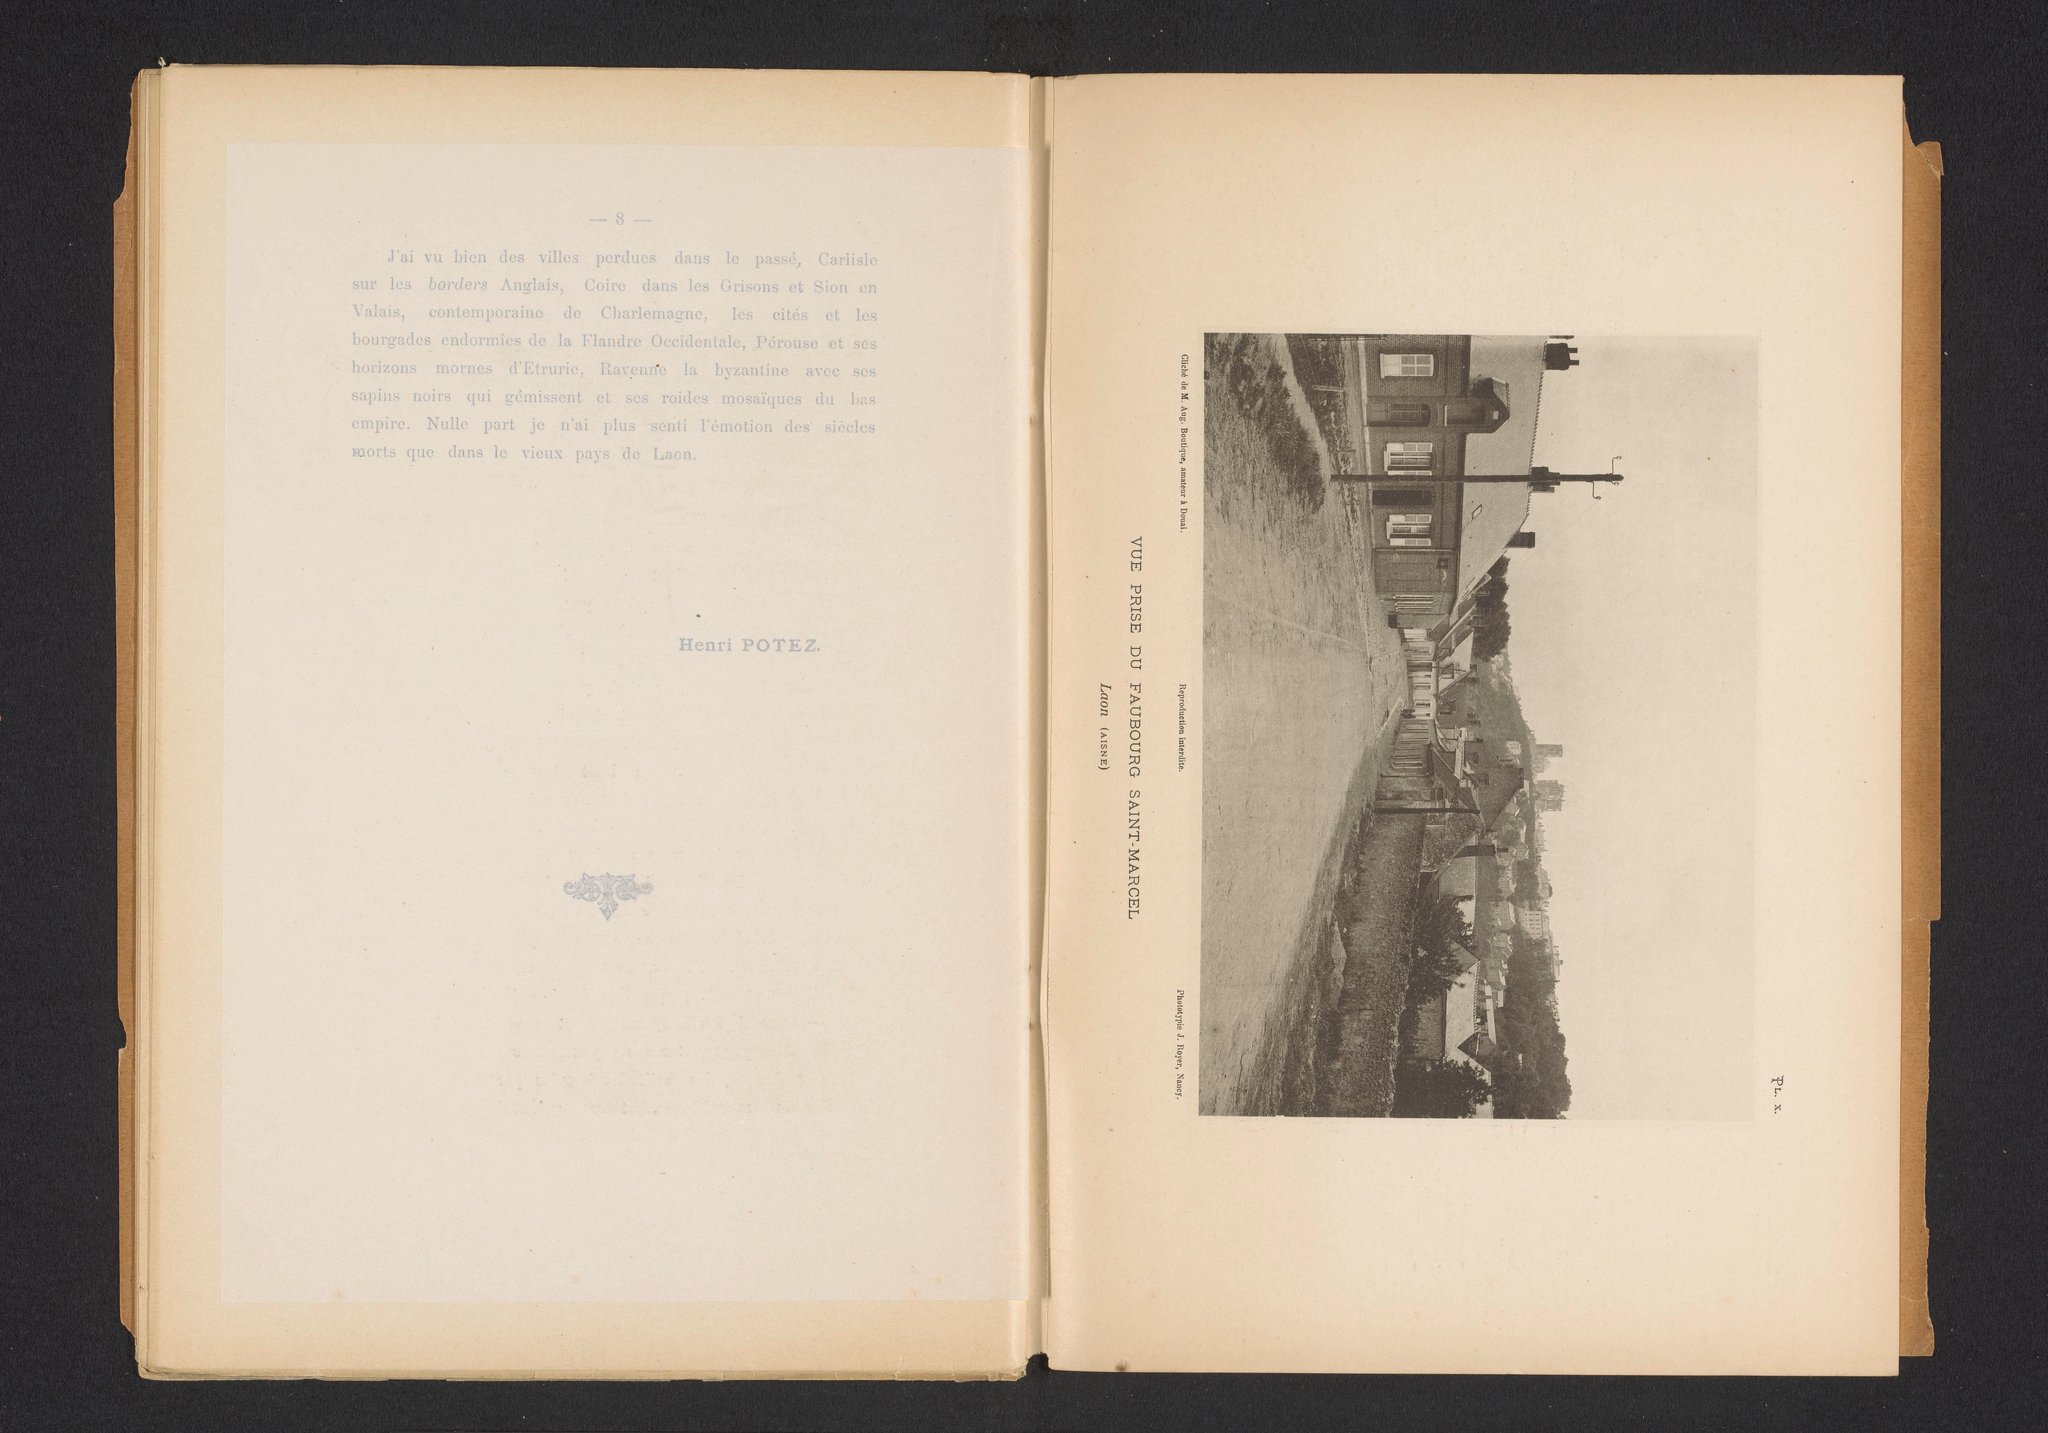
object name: photomechanical print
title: Laon (Aisne)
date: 1891-1896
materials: paper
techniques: photograph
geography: laon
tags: street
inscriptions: number: ‘Pl. X.’, inscription: ‘Reproduction interdite.’